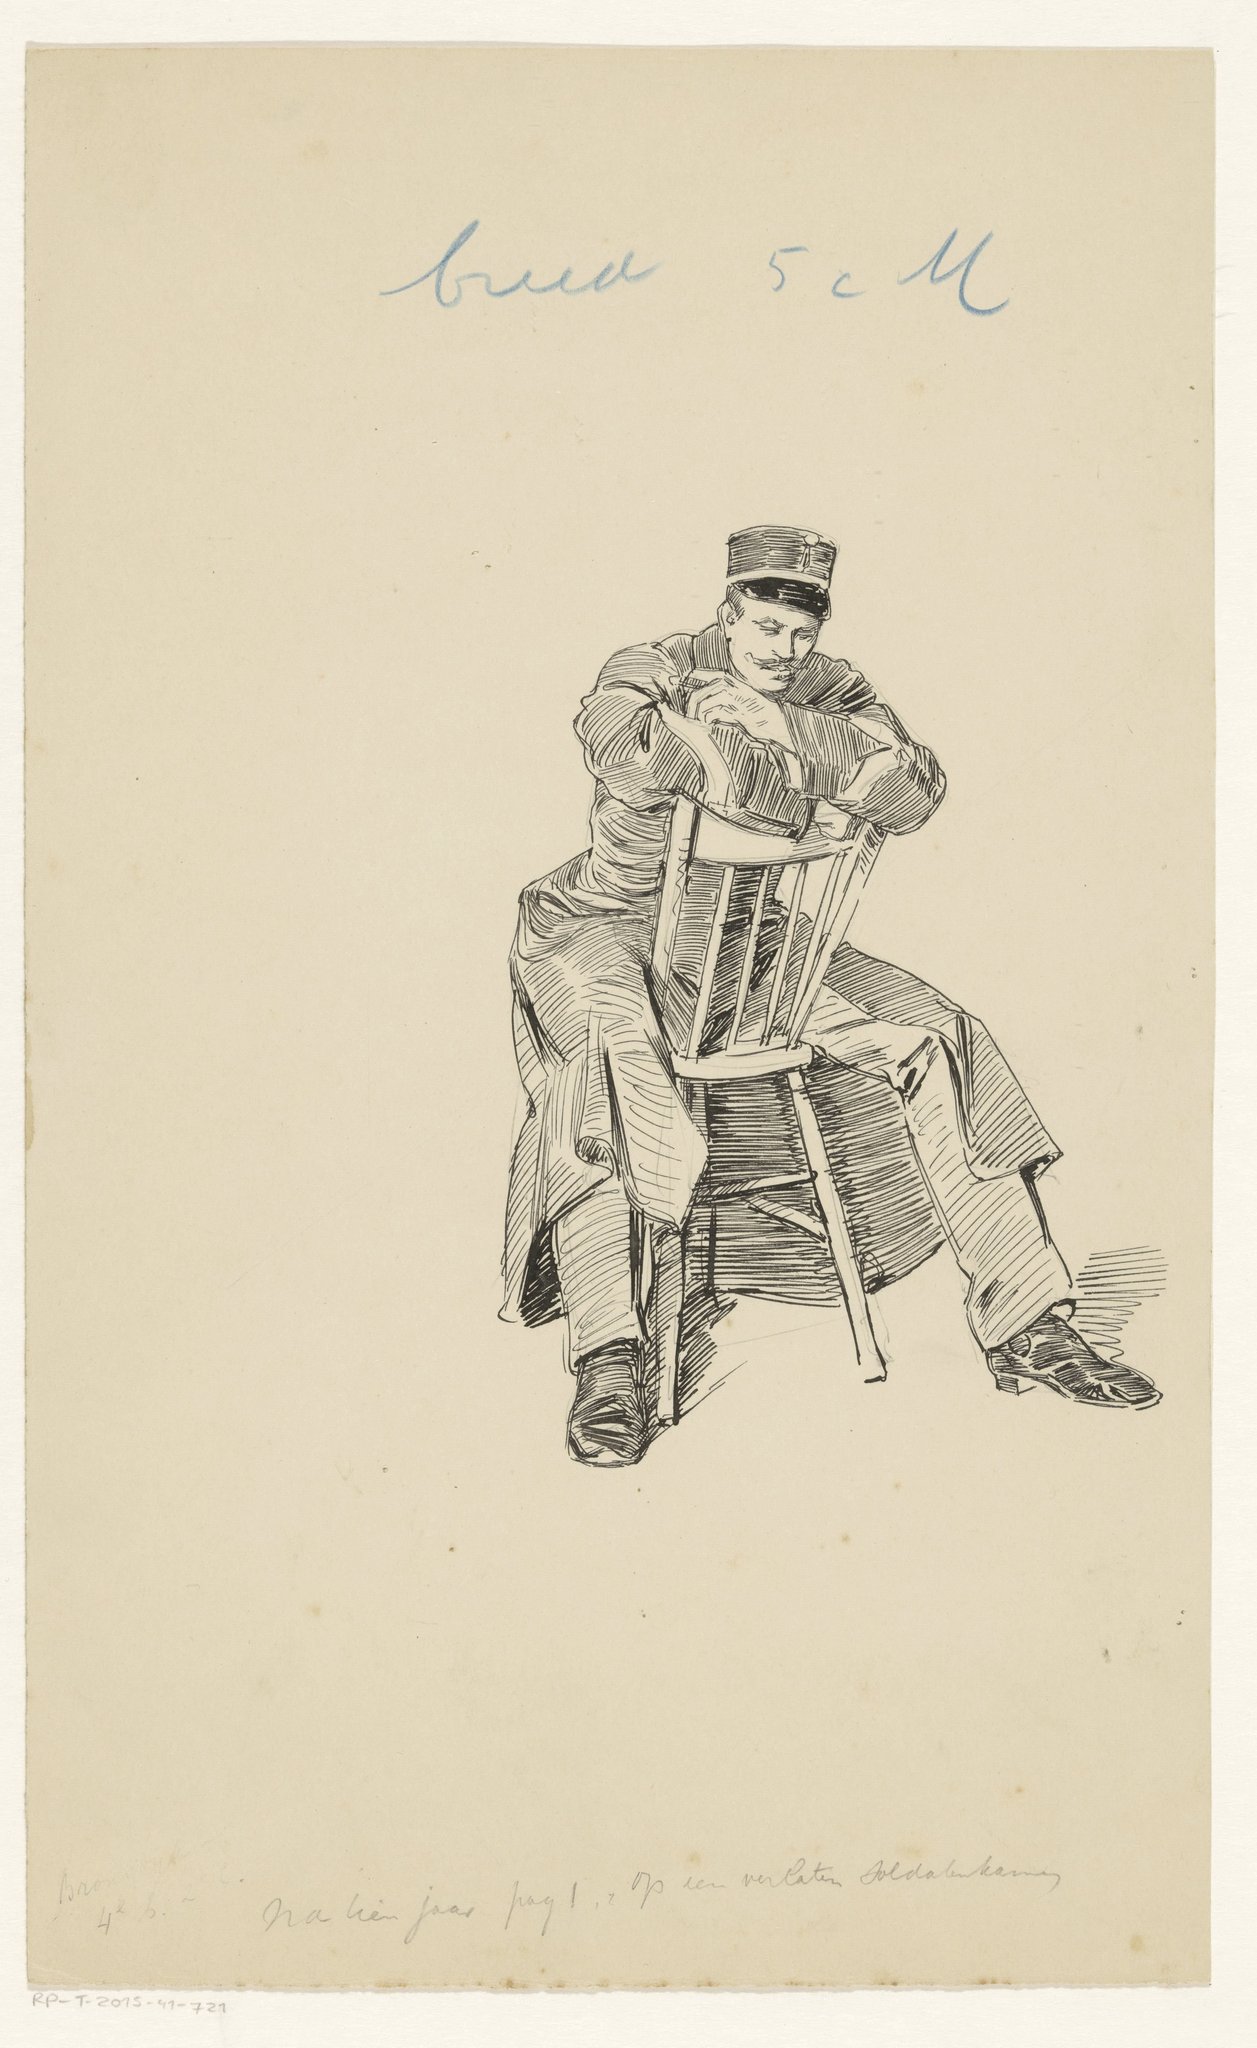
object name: boekillustratie ontwerp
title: Militair zittend op een stoel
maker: heinrich m. krabbé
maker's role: draughtsman, print maker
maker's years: 1868-1931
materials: ink, paper, pencil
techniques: pen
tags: table, the soldier; the soldier's life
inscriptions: :, annotation: ‘Bron[...]dijk/ 4e b. [...]/ Na tien jaar pag 1 "Op een verlaten soldatenkamer’, collector's mark: Lugt 2228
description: Een militair zit omgekeerd op een stoel en steunt met zijn onderarmen op de rugleuning.